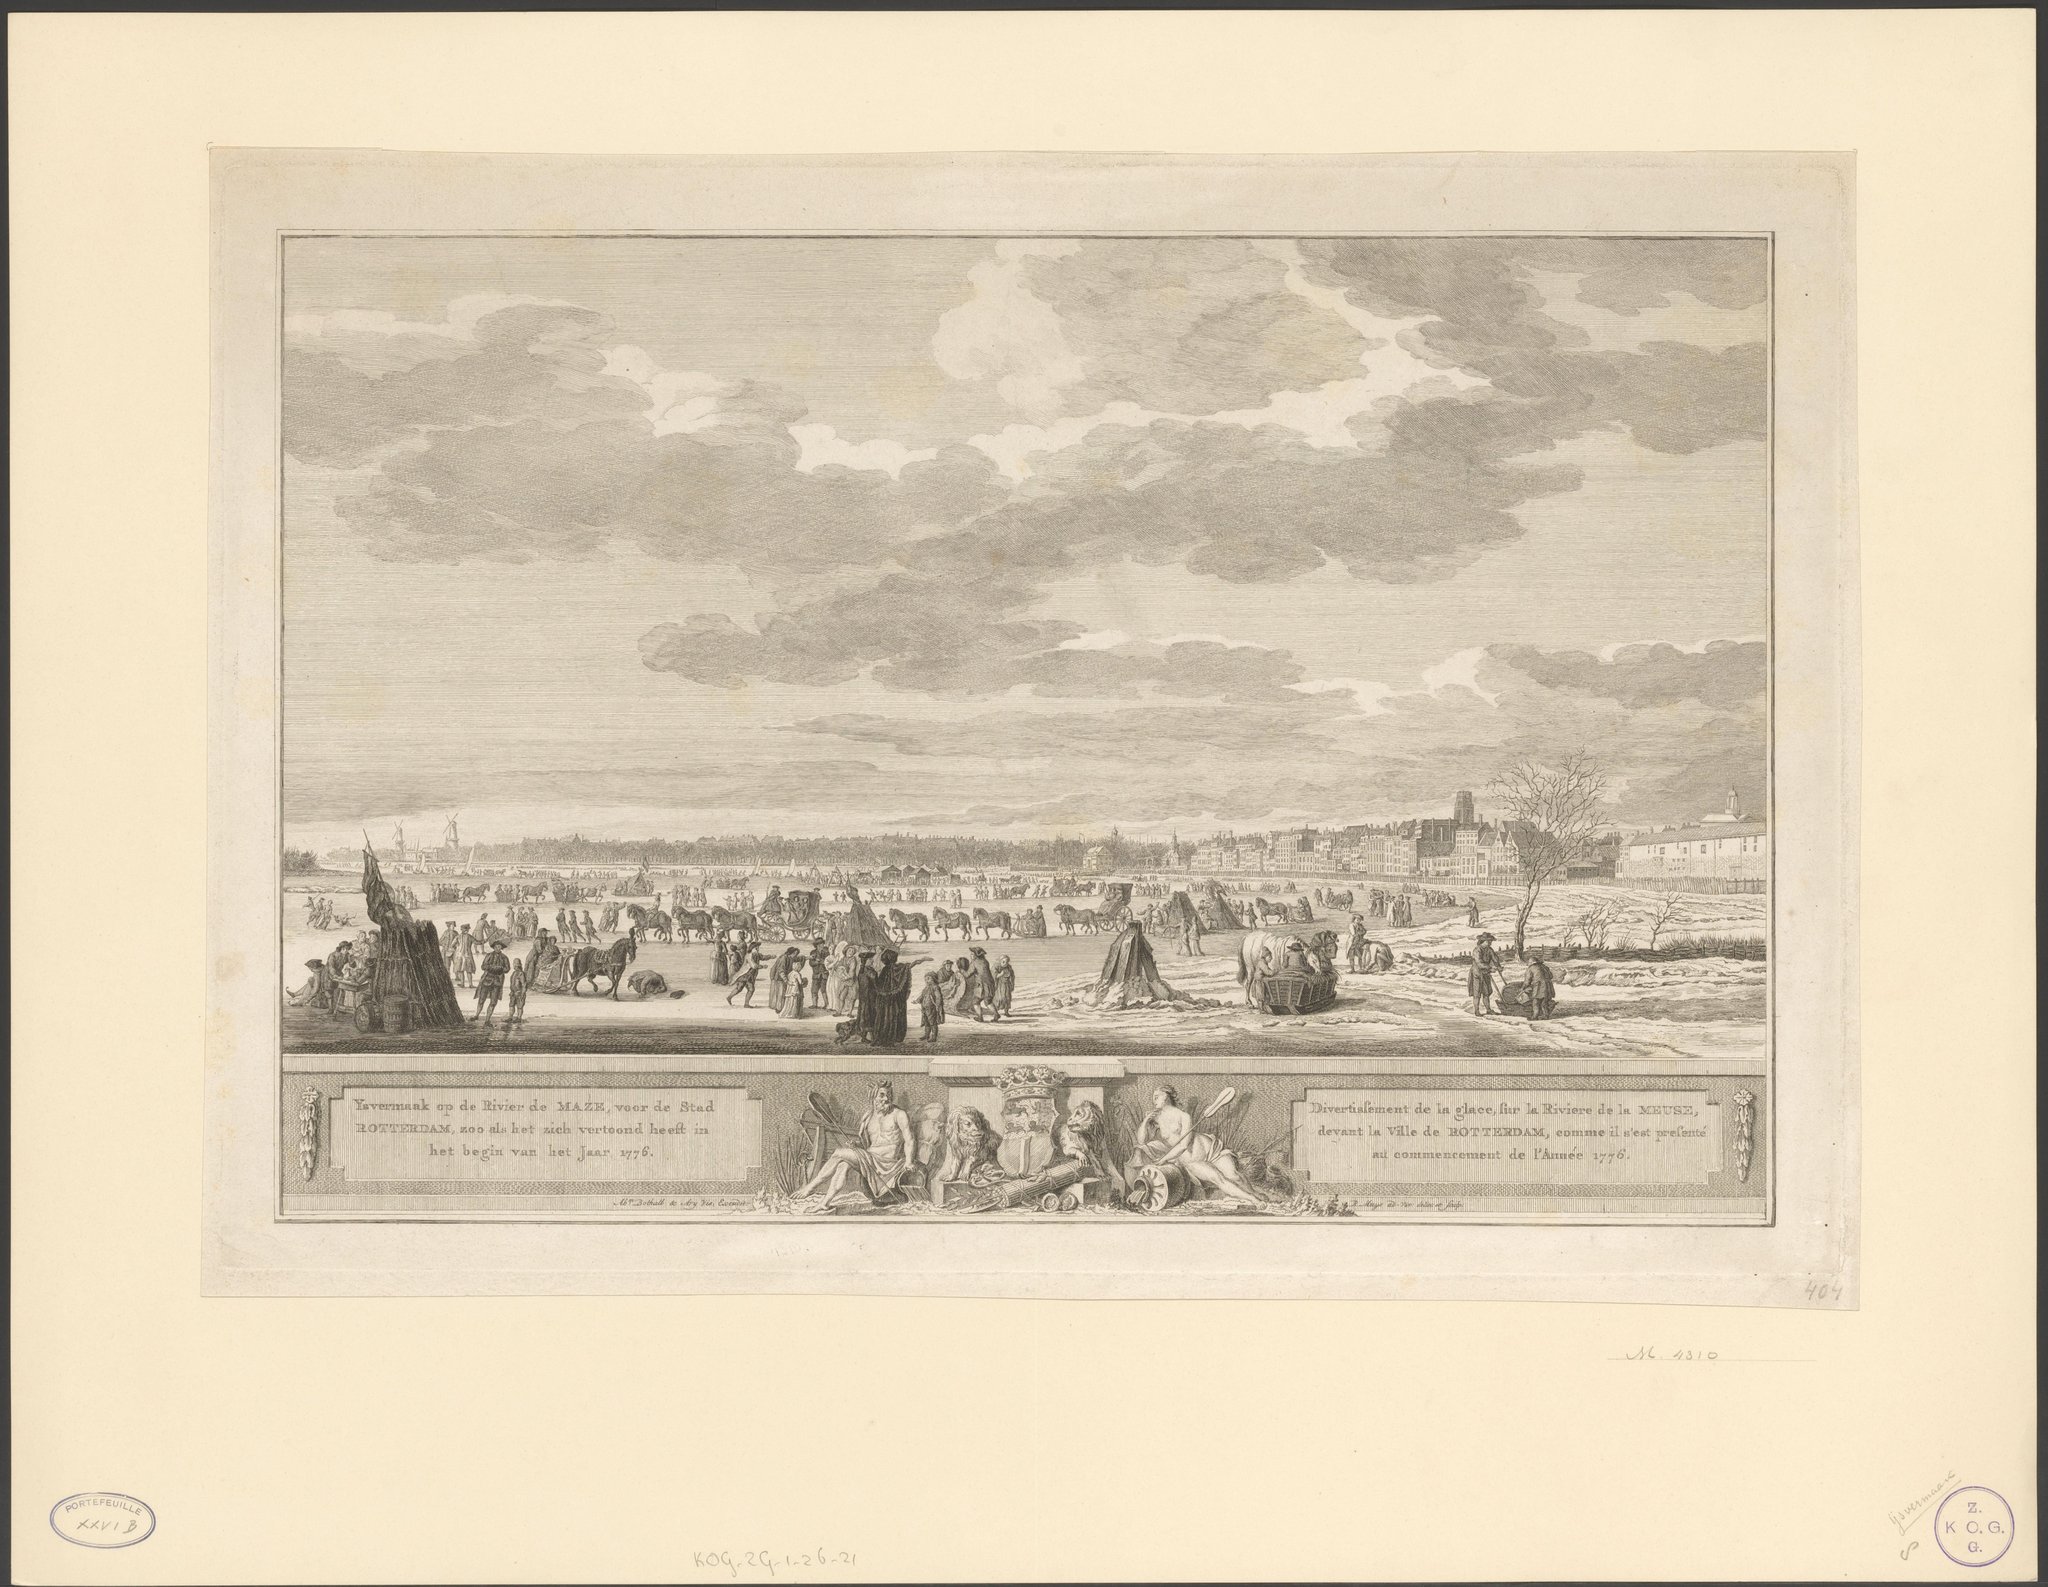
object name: print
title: Ysvermaak op de Rivier de Maze, voor de Stad Rotterdam, zoo als het zich vertoond heeft in het begin van het Jaar 1776 / Divertissement de la glace, sur la Riviere de la Meuse, devant la Ville de Rotterdam, comme il s'est presenté au commencement de l'Année 1776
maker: robbert muys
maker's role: print maker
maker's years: 1742-1825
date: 1776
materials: paper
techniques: engraving, etching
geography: rotterdam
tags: winter sports, severe winters, rotterdam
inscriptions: collector's mark, collector's mark: Lugt 1641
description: Weids gezicht op de bevroren rivier de Maas te Rotterdam aan het begin van 1776 met allerlei vormen van ijsvermaak. Landschap ten zuiden van de Oude-Hoofdpoort, langs de huizen van het Haringvliet, met rijtuigen op het ijs, schaatsen, sledes, koek en zopie etc. Onderaan de titels in het Nederlands en Frans ter weerszijden van een vignet met het wapen van Rotterdam en riviergoden. Onderwerpsrubrieken binnen de Atlas Zeden en Gewoonten: Spel en Vermaak; IJsvermaak, Riviergezichten.